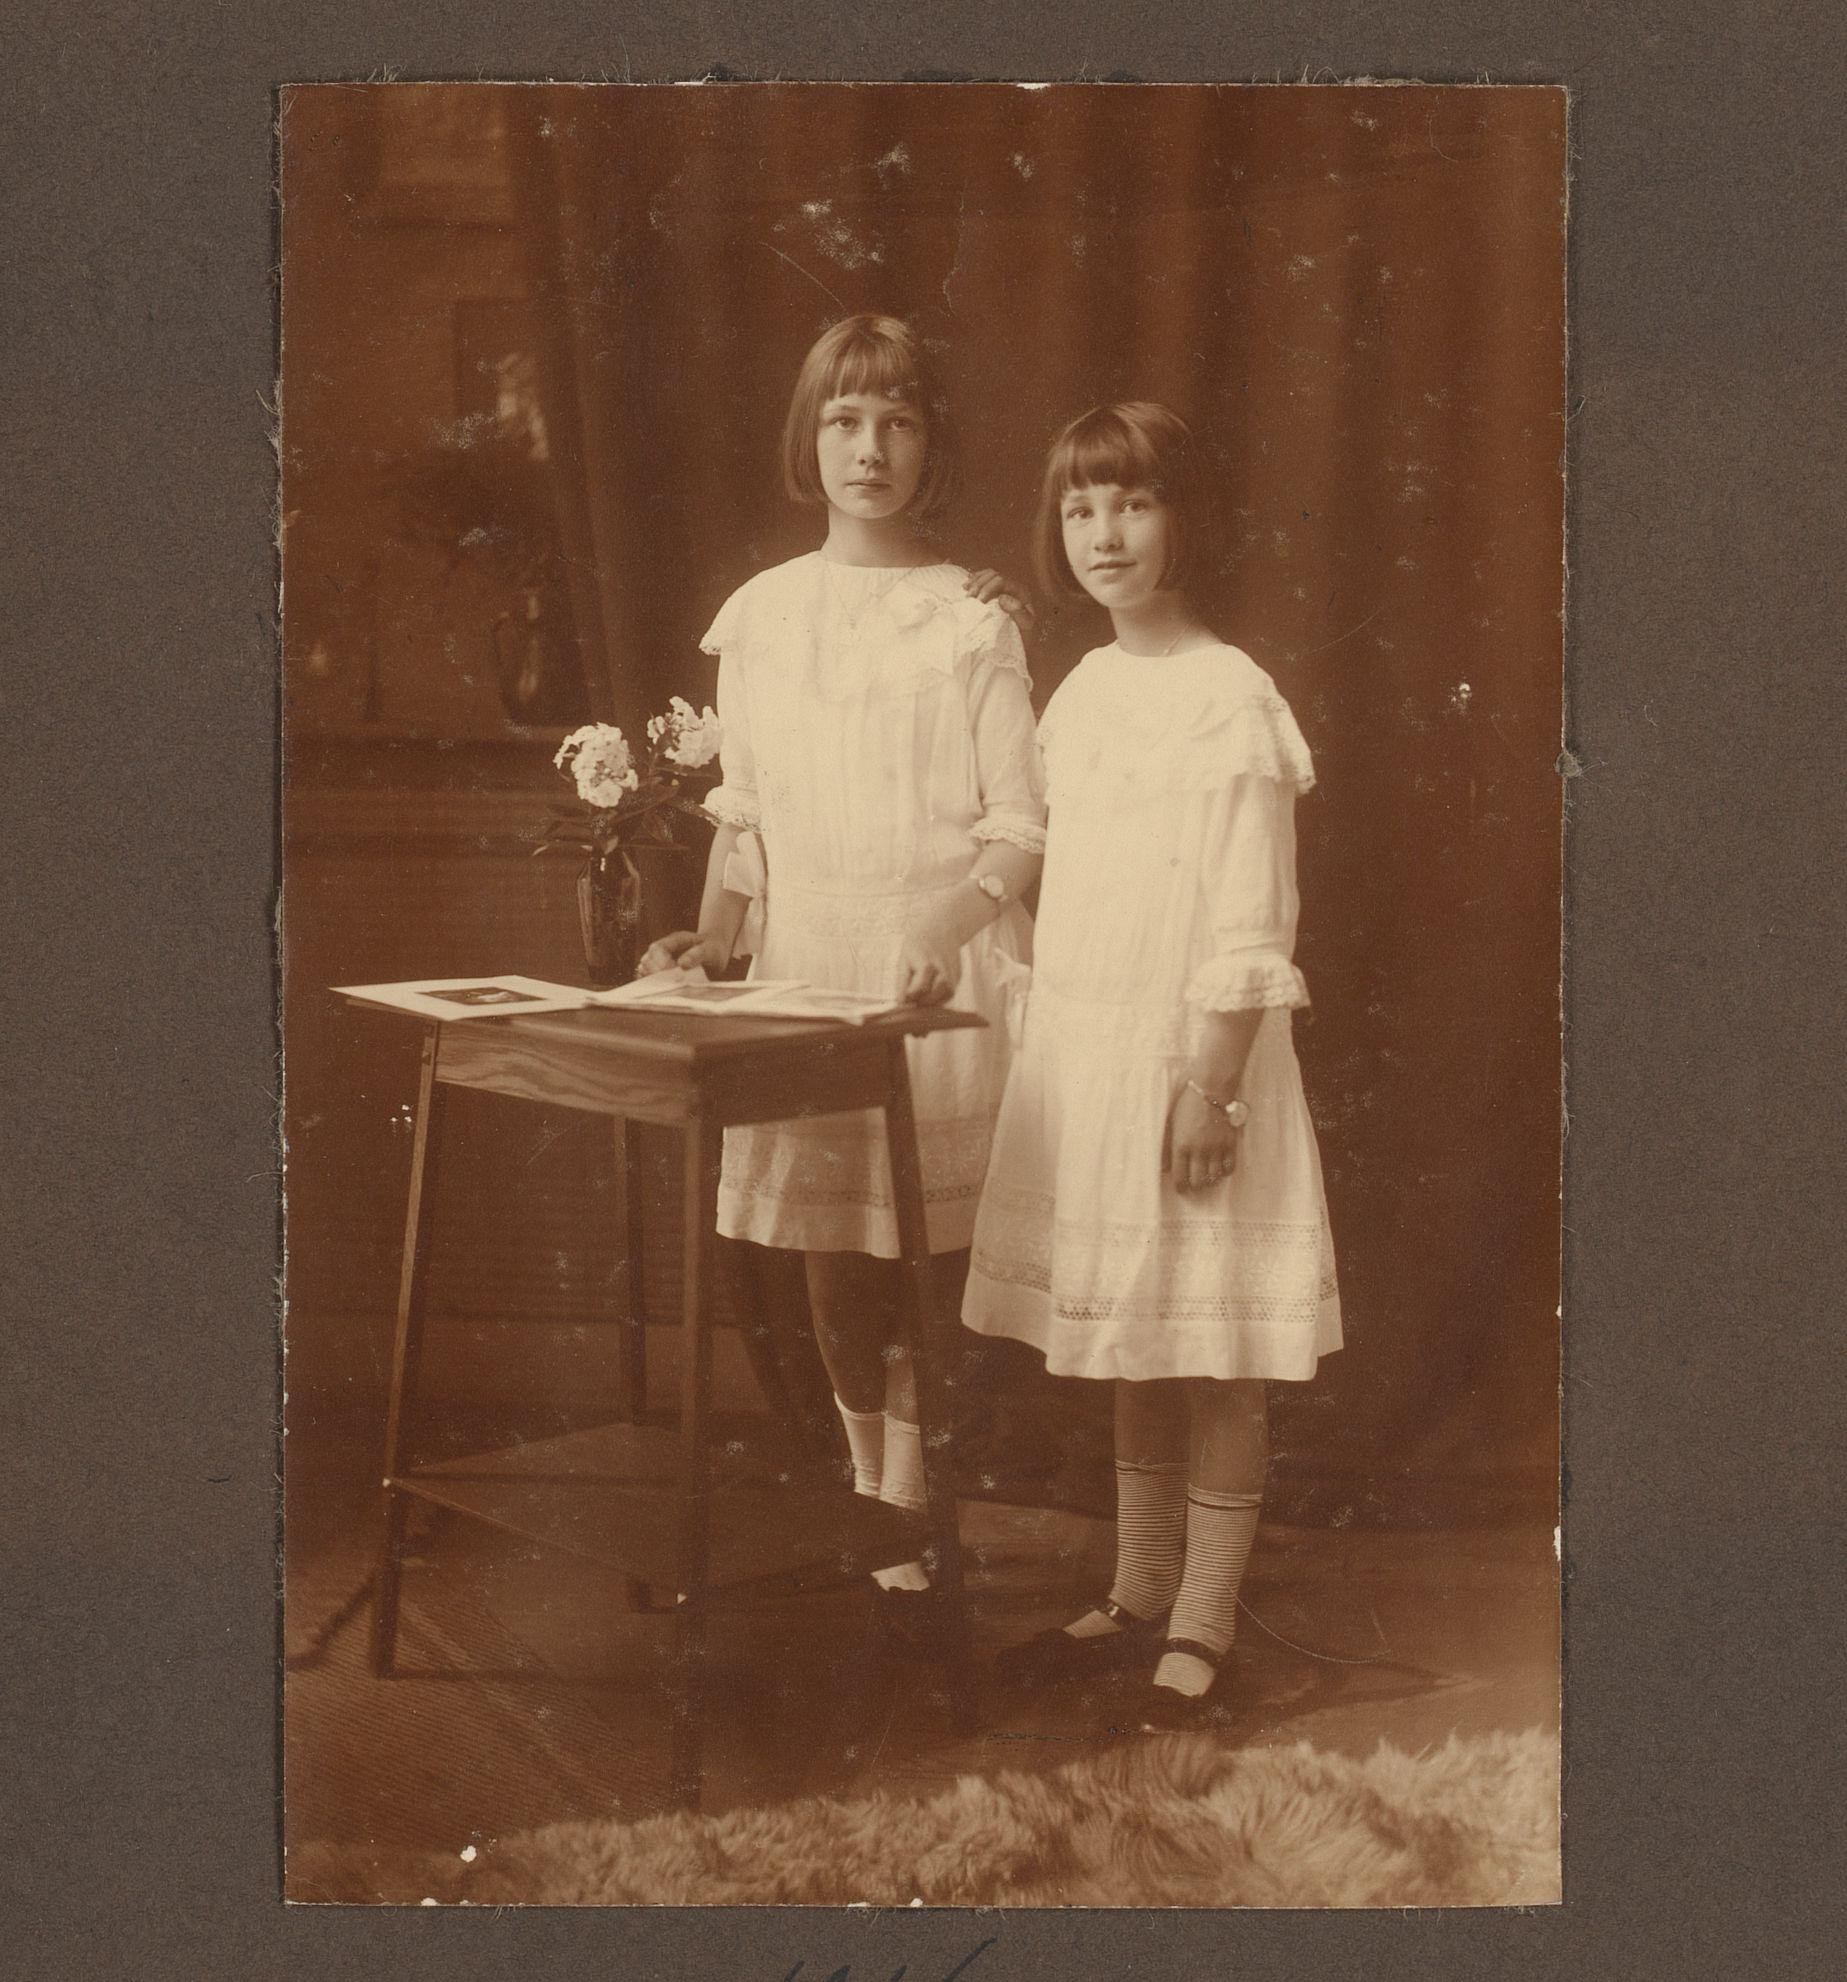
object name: photograph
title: Portret van Joanna en Thea Diepenbrock staand aan een bijzettafel met daarop een vaas bloemen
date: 1916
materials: paper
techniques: gelatin silver print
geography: netherlands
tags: historical persons - bb - woman, table, flowers in a vase, sisters (second degree family relationships)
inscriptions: date: ‘1916.’